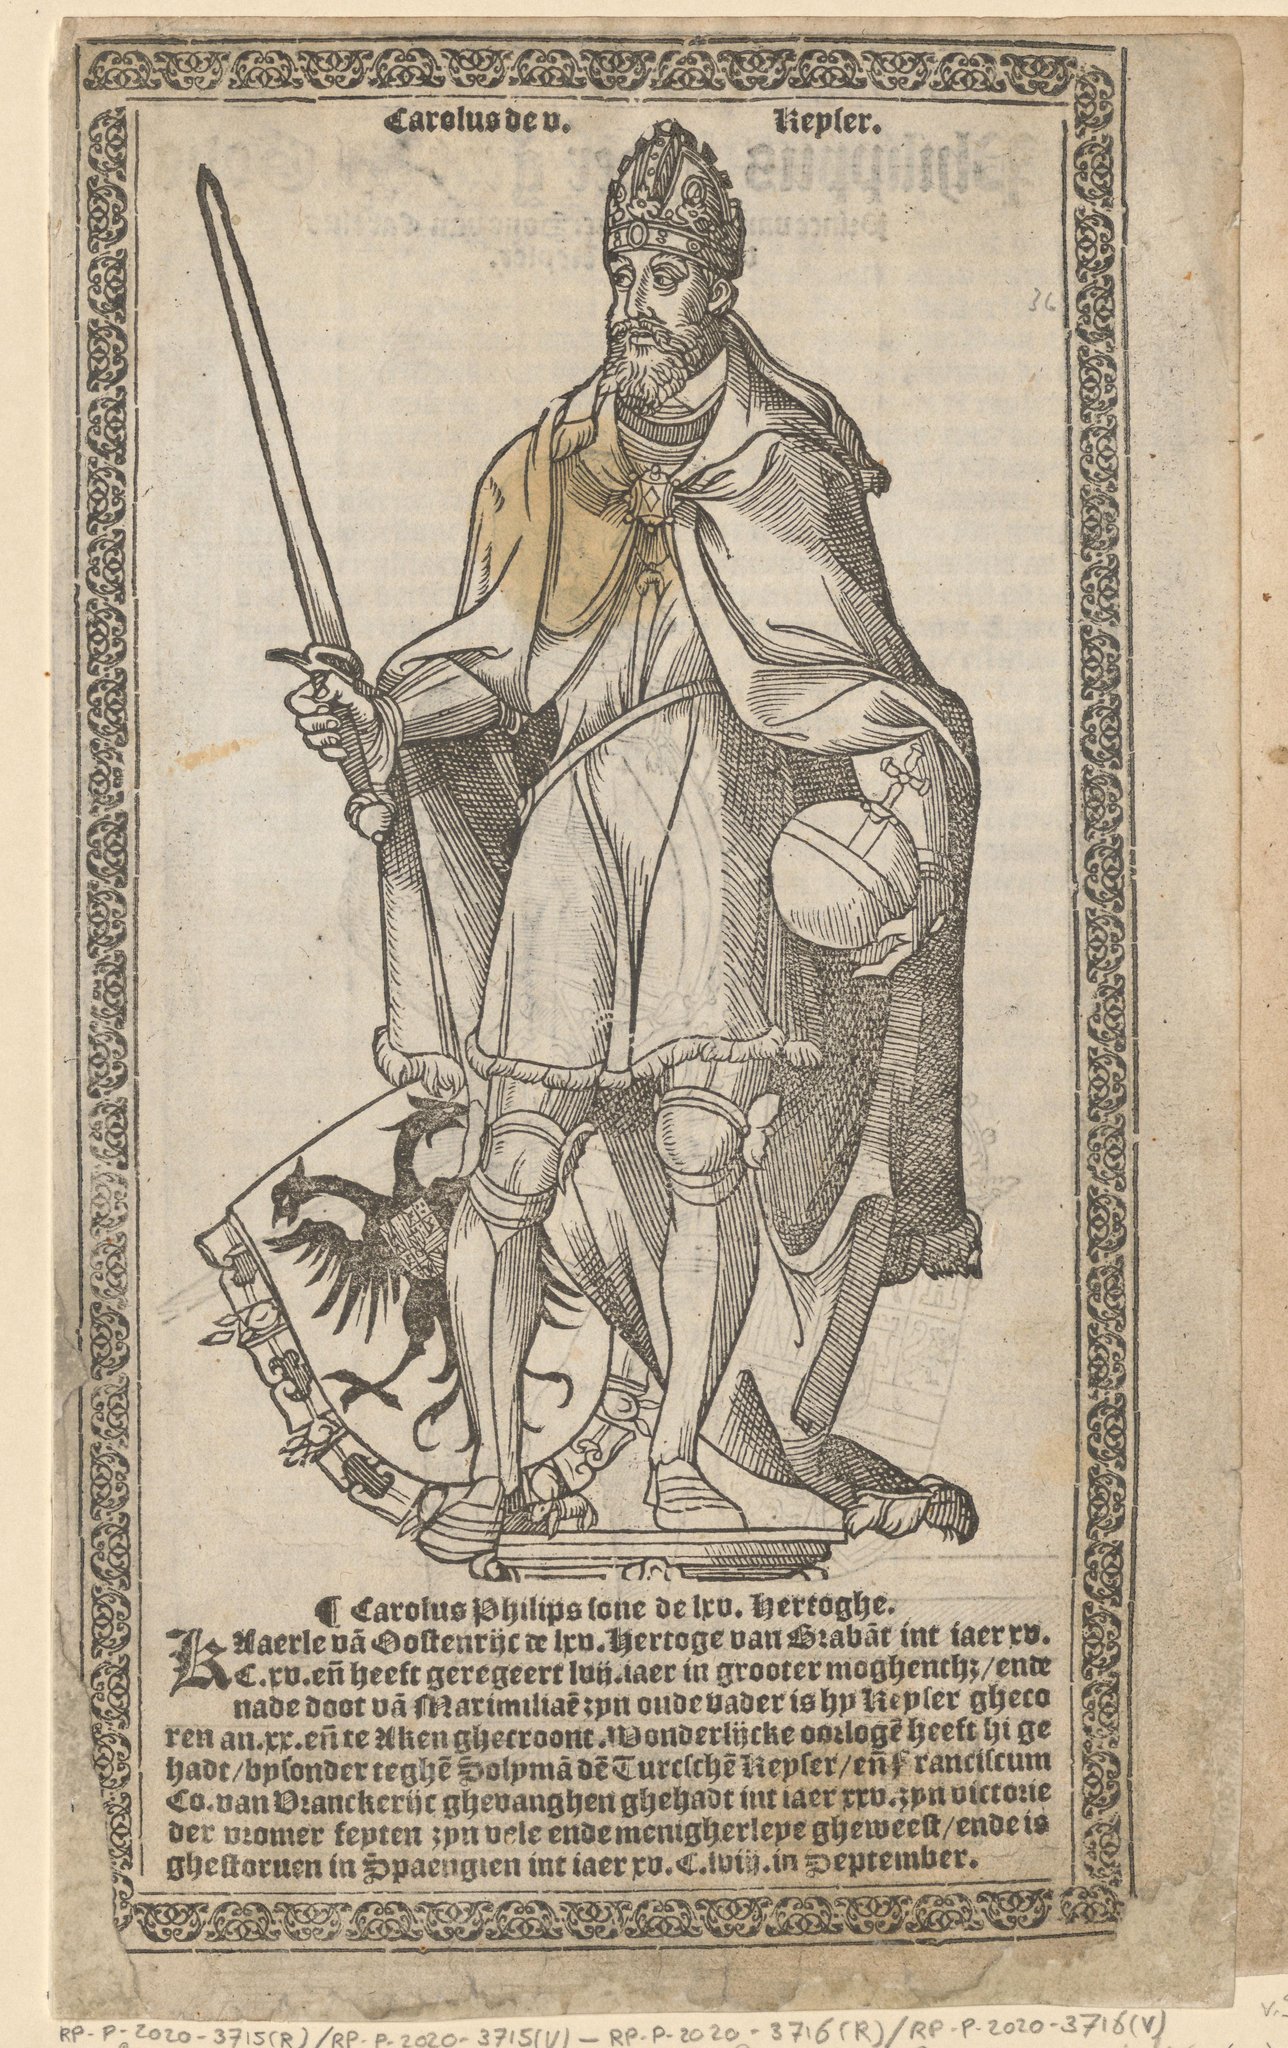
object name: book illustration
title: Portret van keizer Karel V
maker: jan molijns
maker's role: print maker, publisher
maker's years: 1498-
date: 1565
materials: paper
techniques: letterpress printing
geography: antwerp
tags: charles v (holy roman emperor and king of spain), historical persons, hacking and thrusting weapons: sword, emperor, armorial bearing, heraldry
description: Prent uit: Dit is die afcoemste ende genalogie der hertoghen ende hertoginnen van Brabandt, (...). Antwerpen: Jan Molijns, 1565.